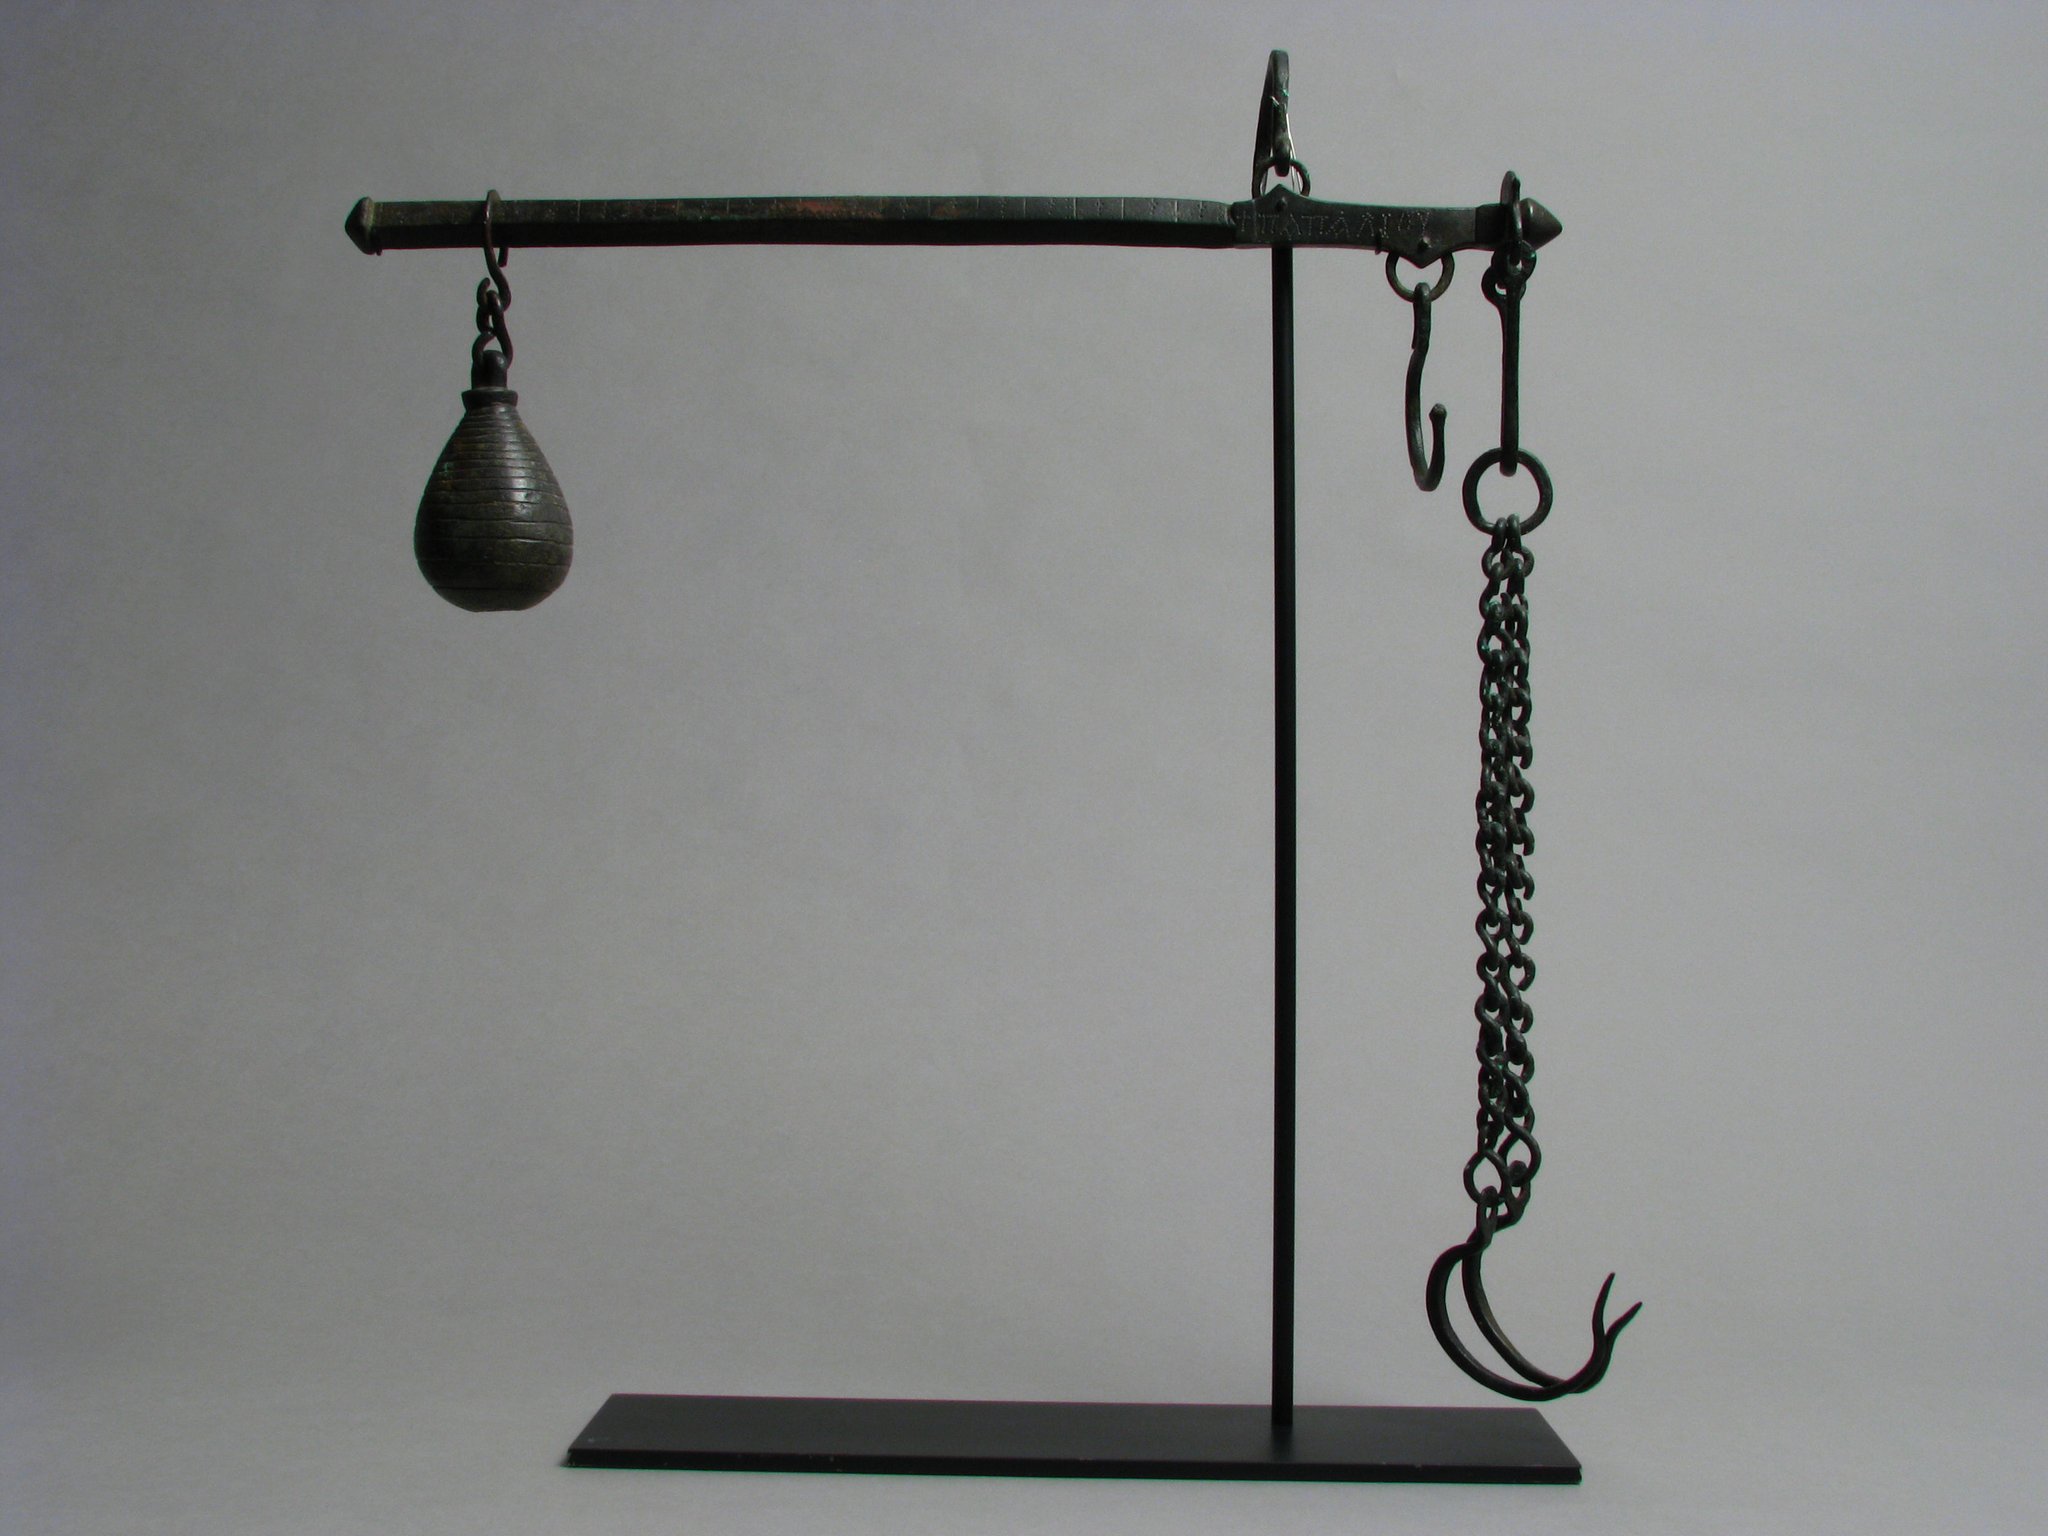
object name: weight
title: Steelyard Rod with Weight and Hooks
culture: byzantine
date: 401-700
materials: copper alloy